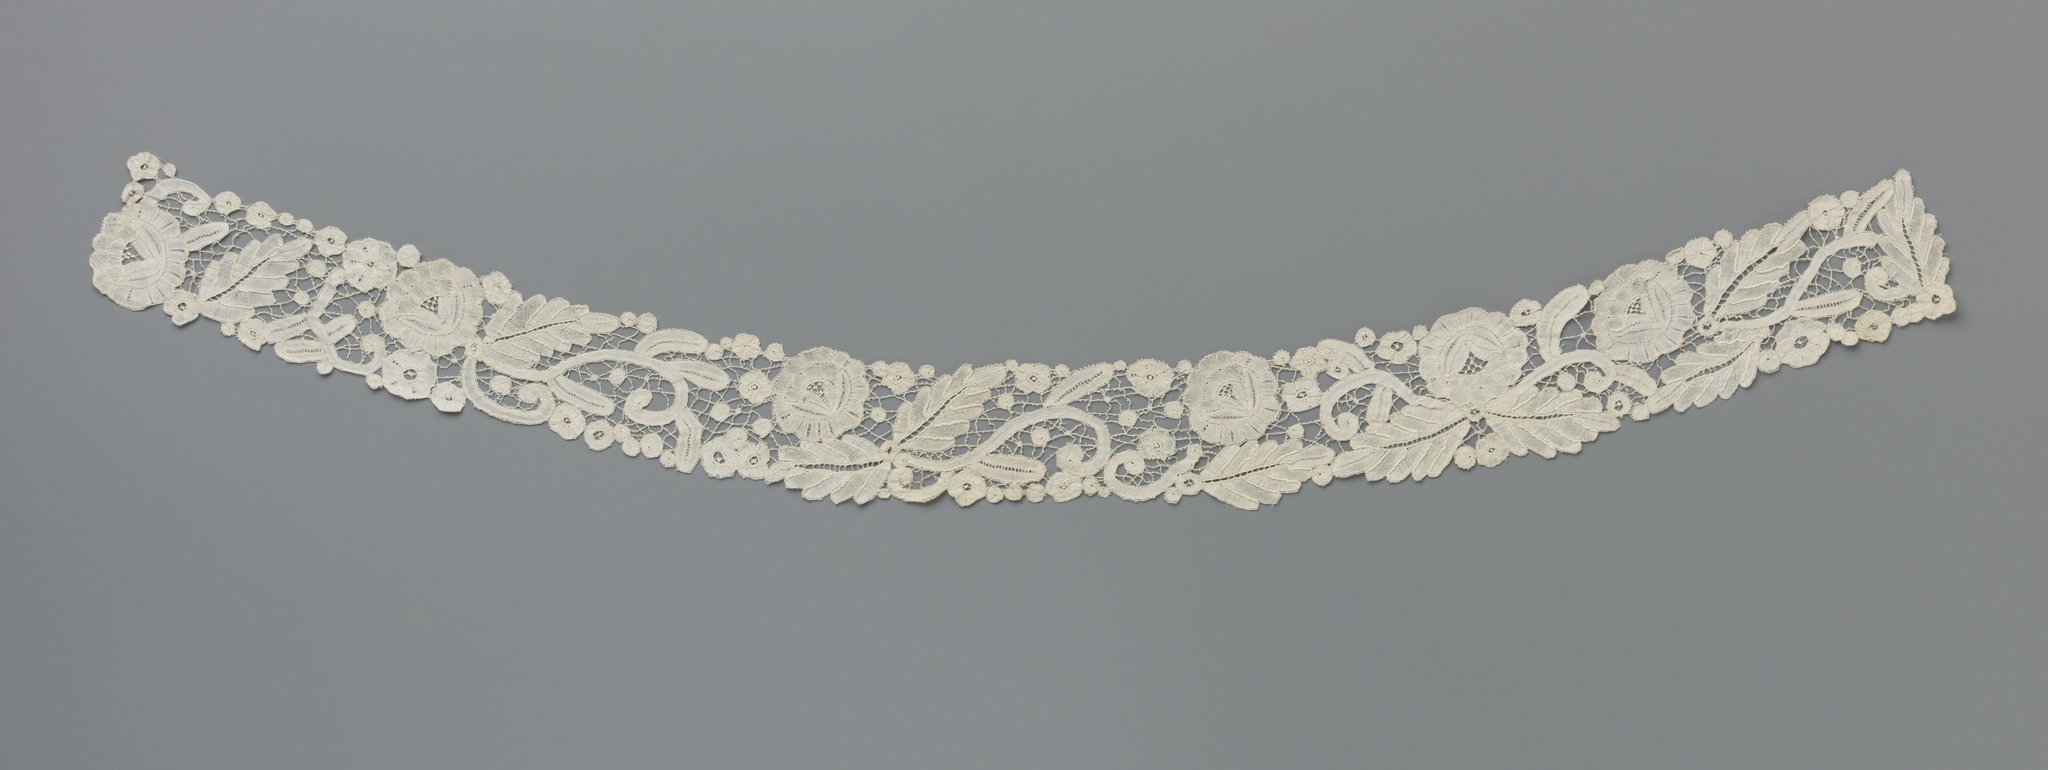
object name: sierstuk, sierobject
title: Sierstuk voor een avondmantel van gemengde kant met rozenhaag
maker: martha berkers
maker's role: kantwerkster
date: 1915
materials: linen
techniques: lace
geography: sluis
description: Sierstuk voor een avondmantel van naturelkleurige gemengde kant - kloskant in combinatie met naaldkant - Brusselse duchesse. Op een wijd gespreide vlechtengrond staan rozen die meestal op twee bladeren steunen. Een tussenornament bestaat uit enkele en dubbele voluutranken en vele kleine bloempjes.